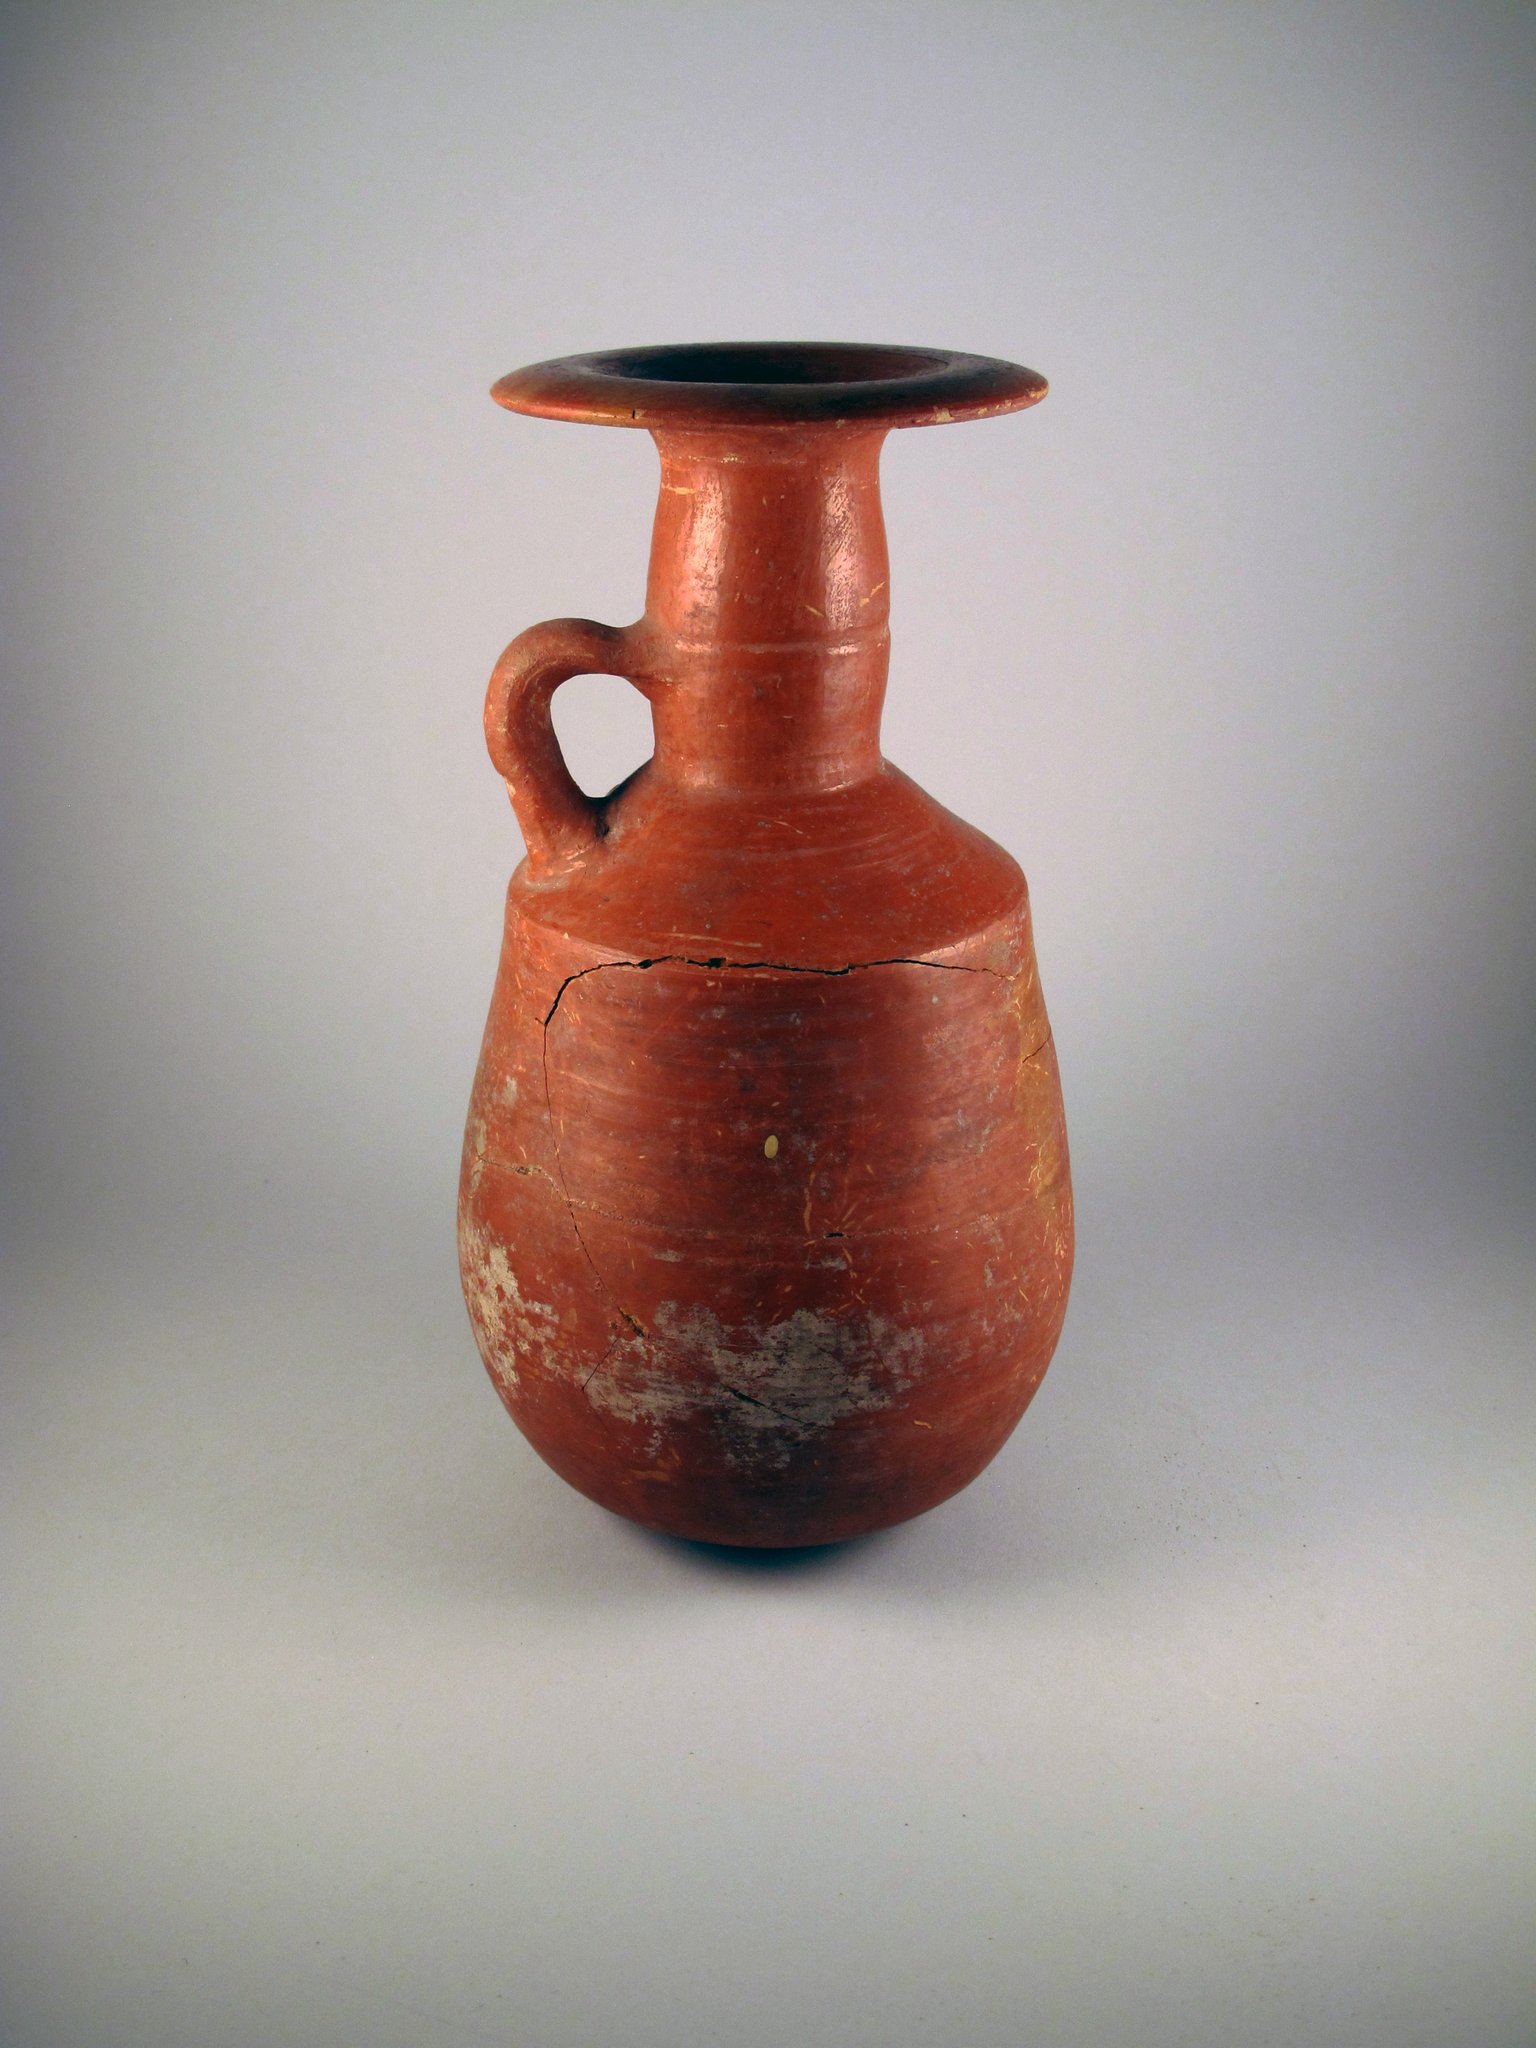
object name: jug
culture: cypriot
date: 600-480 BCE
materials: terracotta